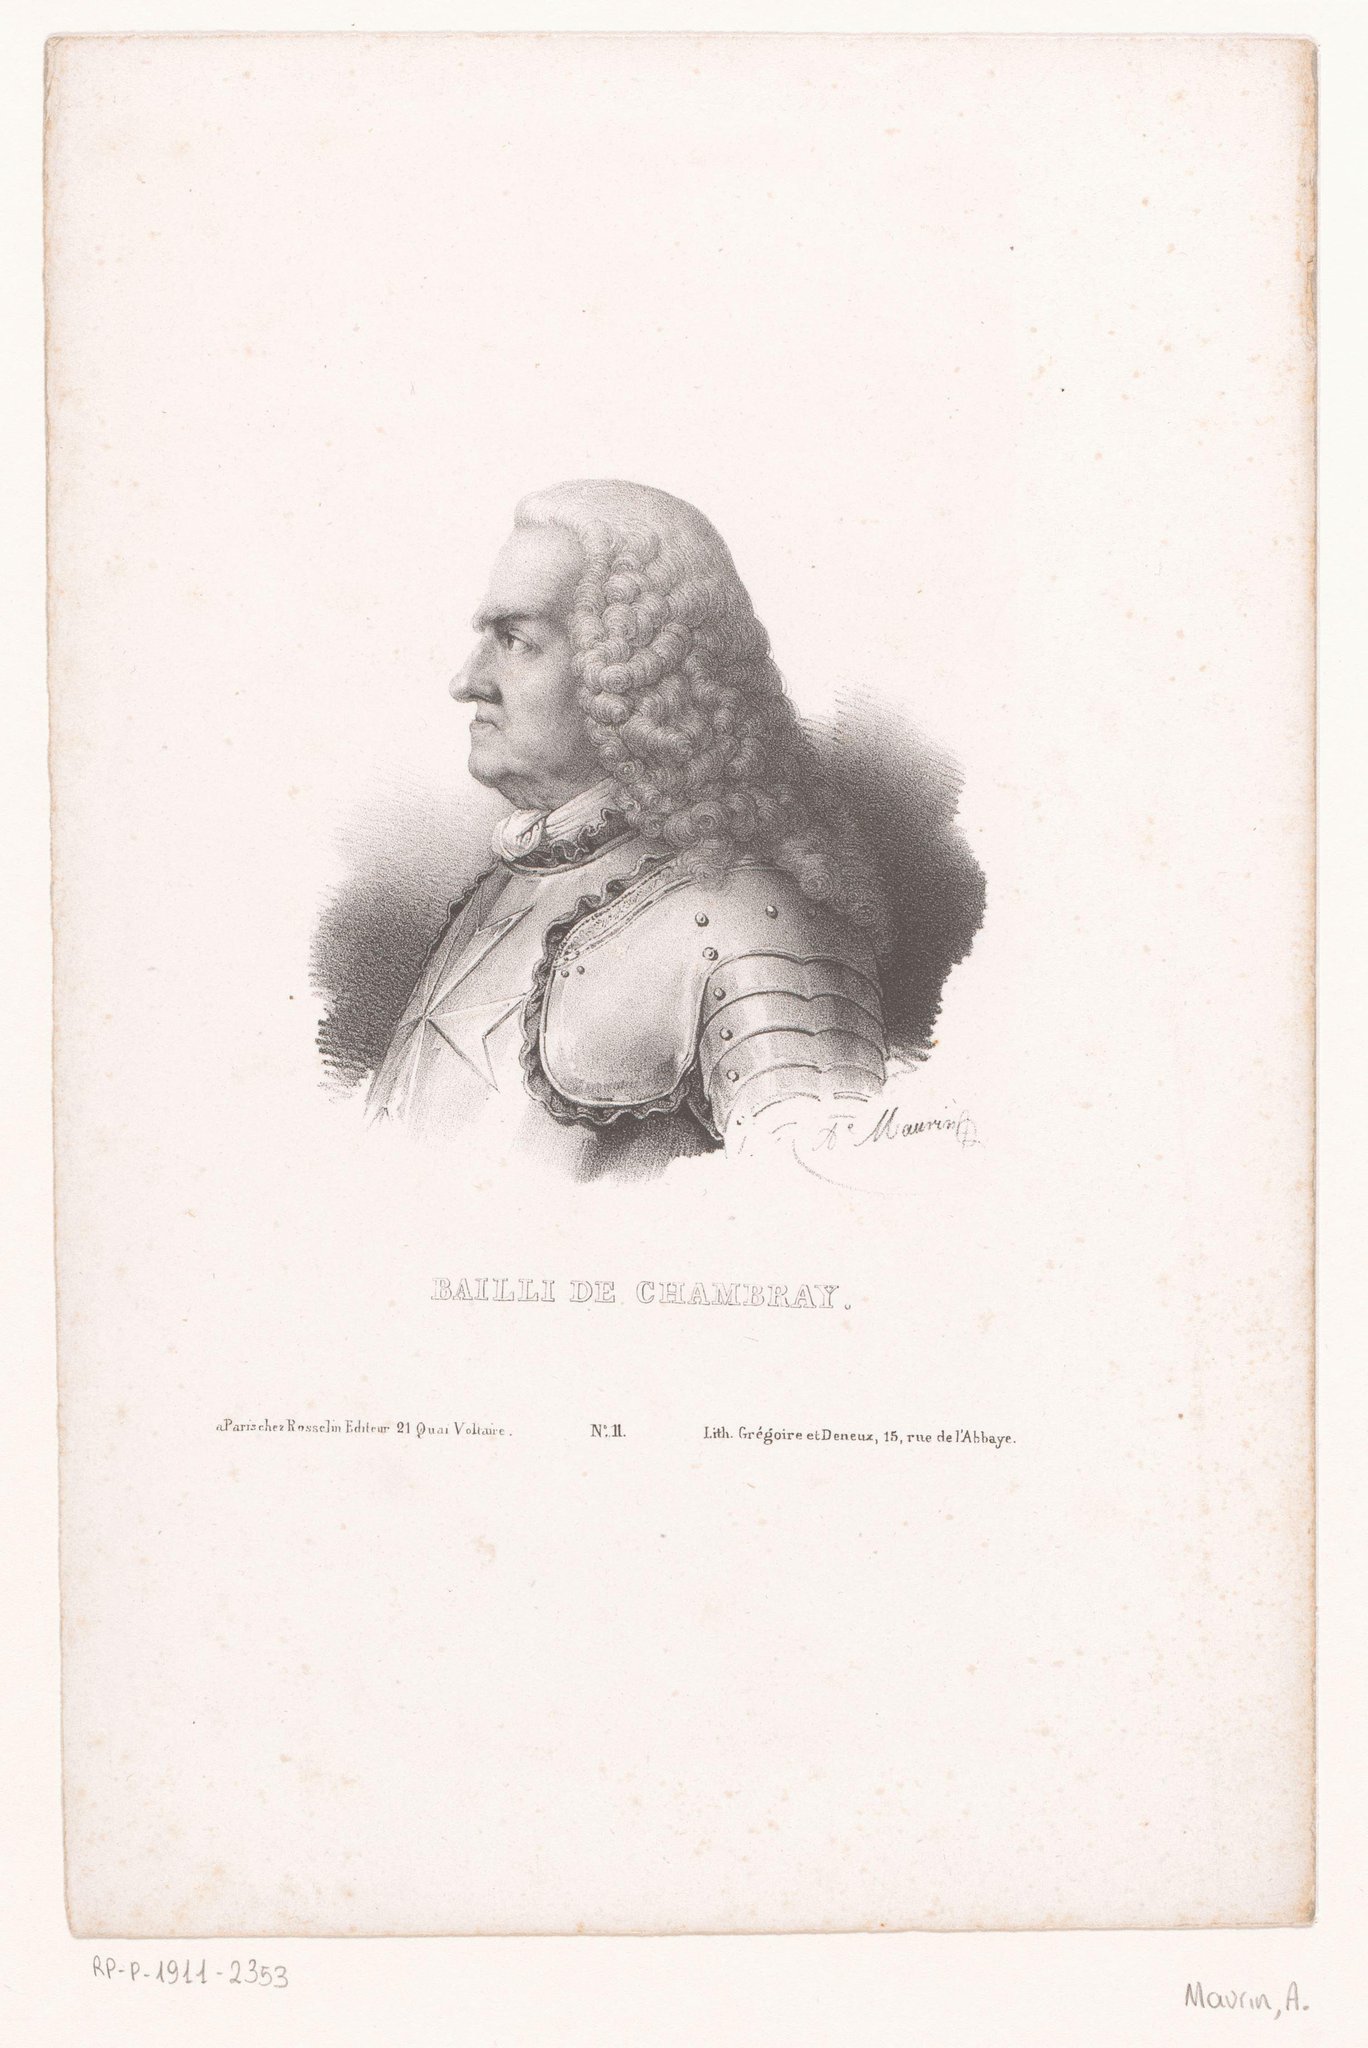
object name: print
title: Portret van baljuw Jacques-François de Chambray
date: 1836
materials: paper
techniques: lithograph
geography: paris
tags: historical persons, bailiff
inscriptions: collector's mark: Lugt 2228